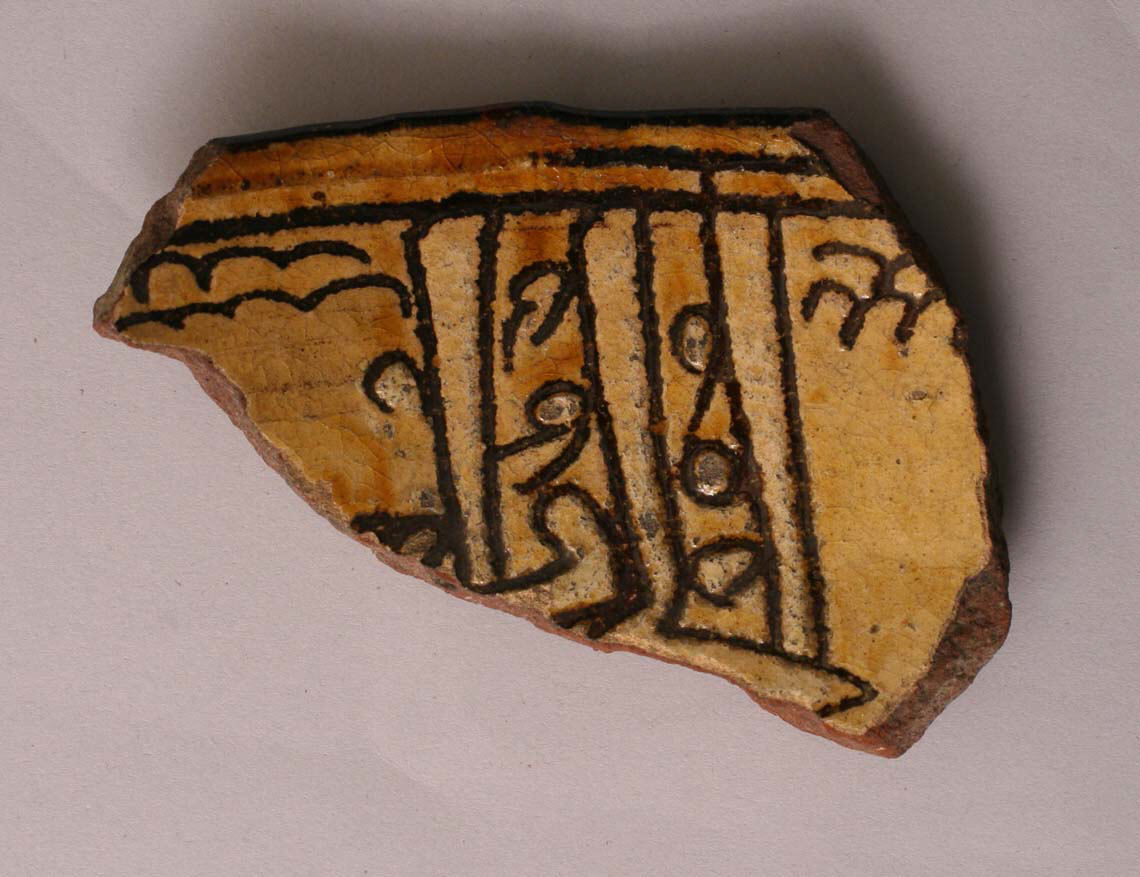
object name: fragment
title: Ceramic Fragment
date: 1301-1500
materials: earthenware, glaze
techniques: coloring, incising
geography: egypt